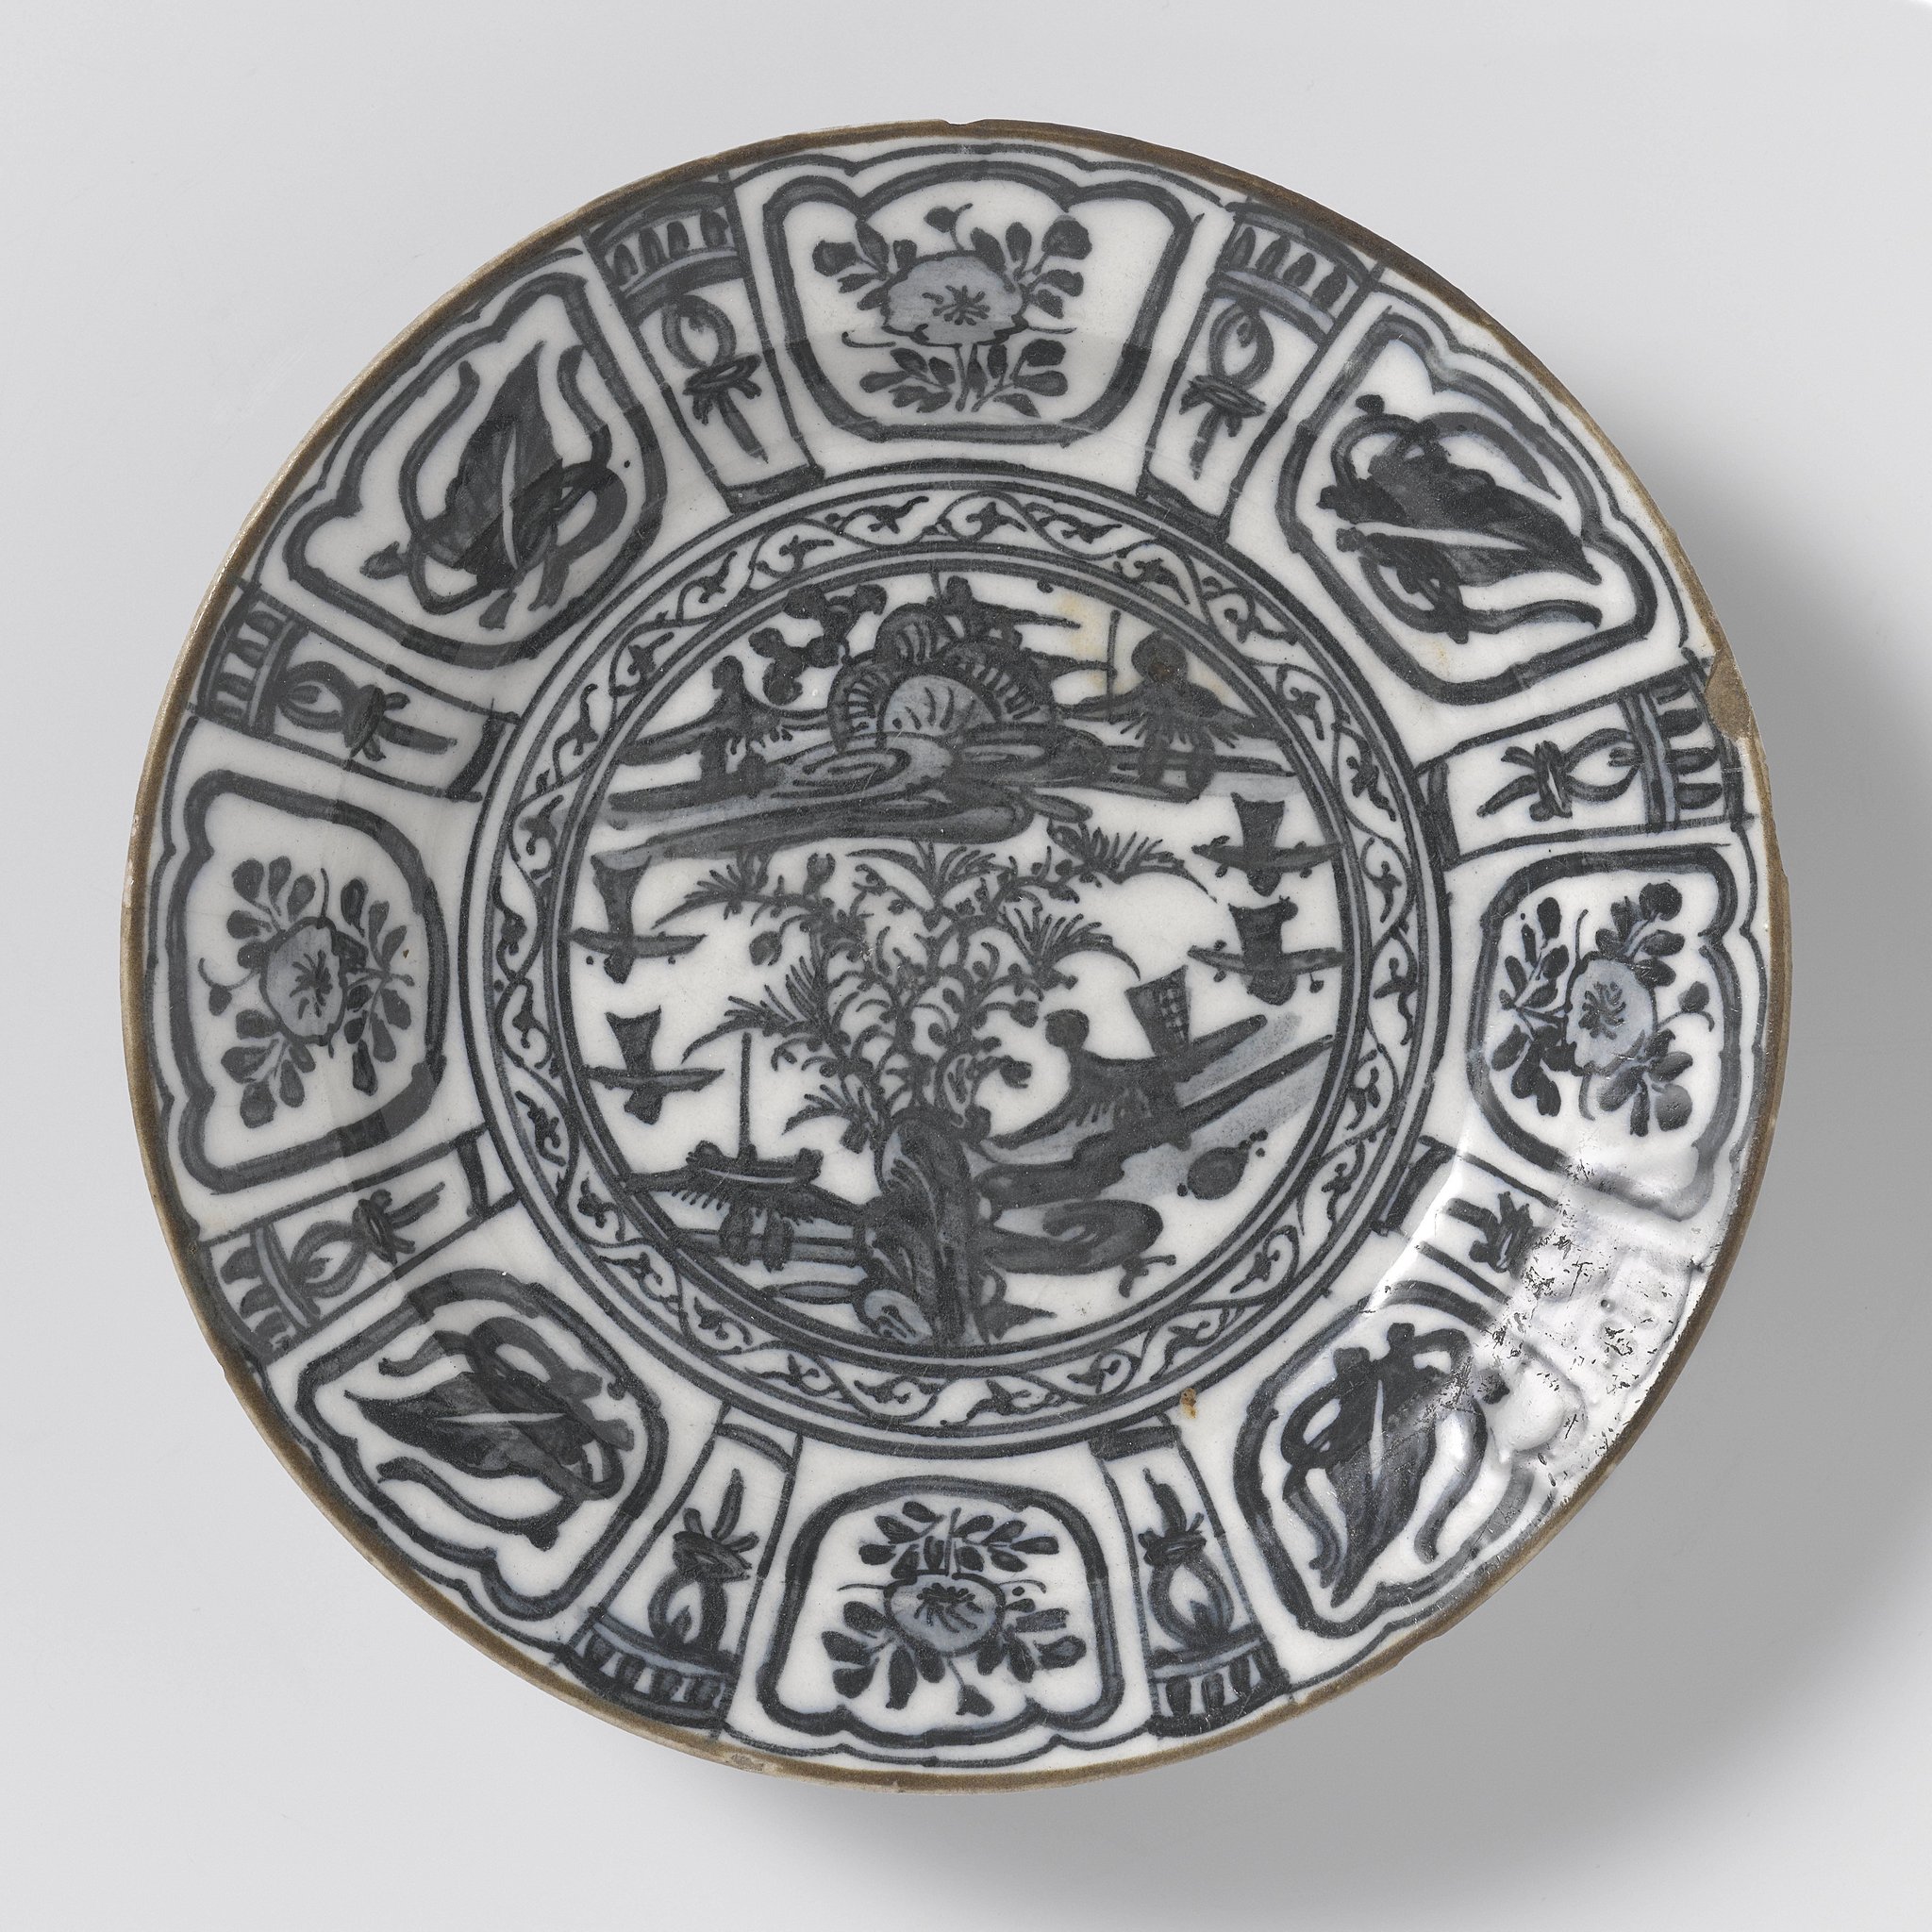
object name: plate dish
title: Plate with a water landscape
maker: Anonymous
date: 1600-1699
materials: cobalt, earthenware, glaze, paint, quartz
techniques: firing, turning, vitrification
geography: kerman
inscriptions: mark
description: This plate was produced in Kerman in southeast Iran. It is decorated with a central Chinese landscape, enclosed by narrow panels containing propitious symbols alternating with wider panels with flowers and banana leaves. The dish is signed on the back by the potter ‘Made by Kamâl al-Din Muhammad.’